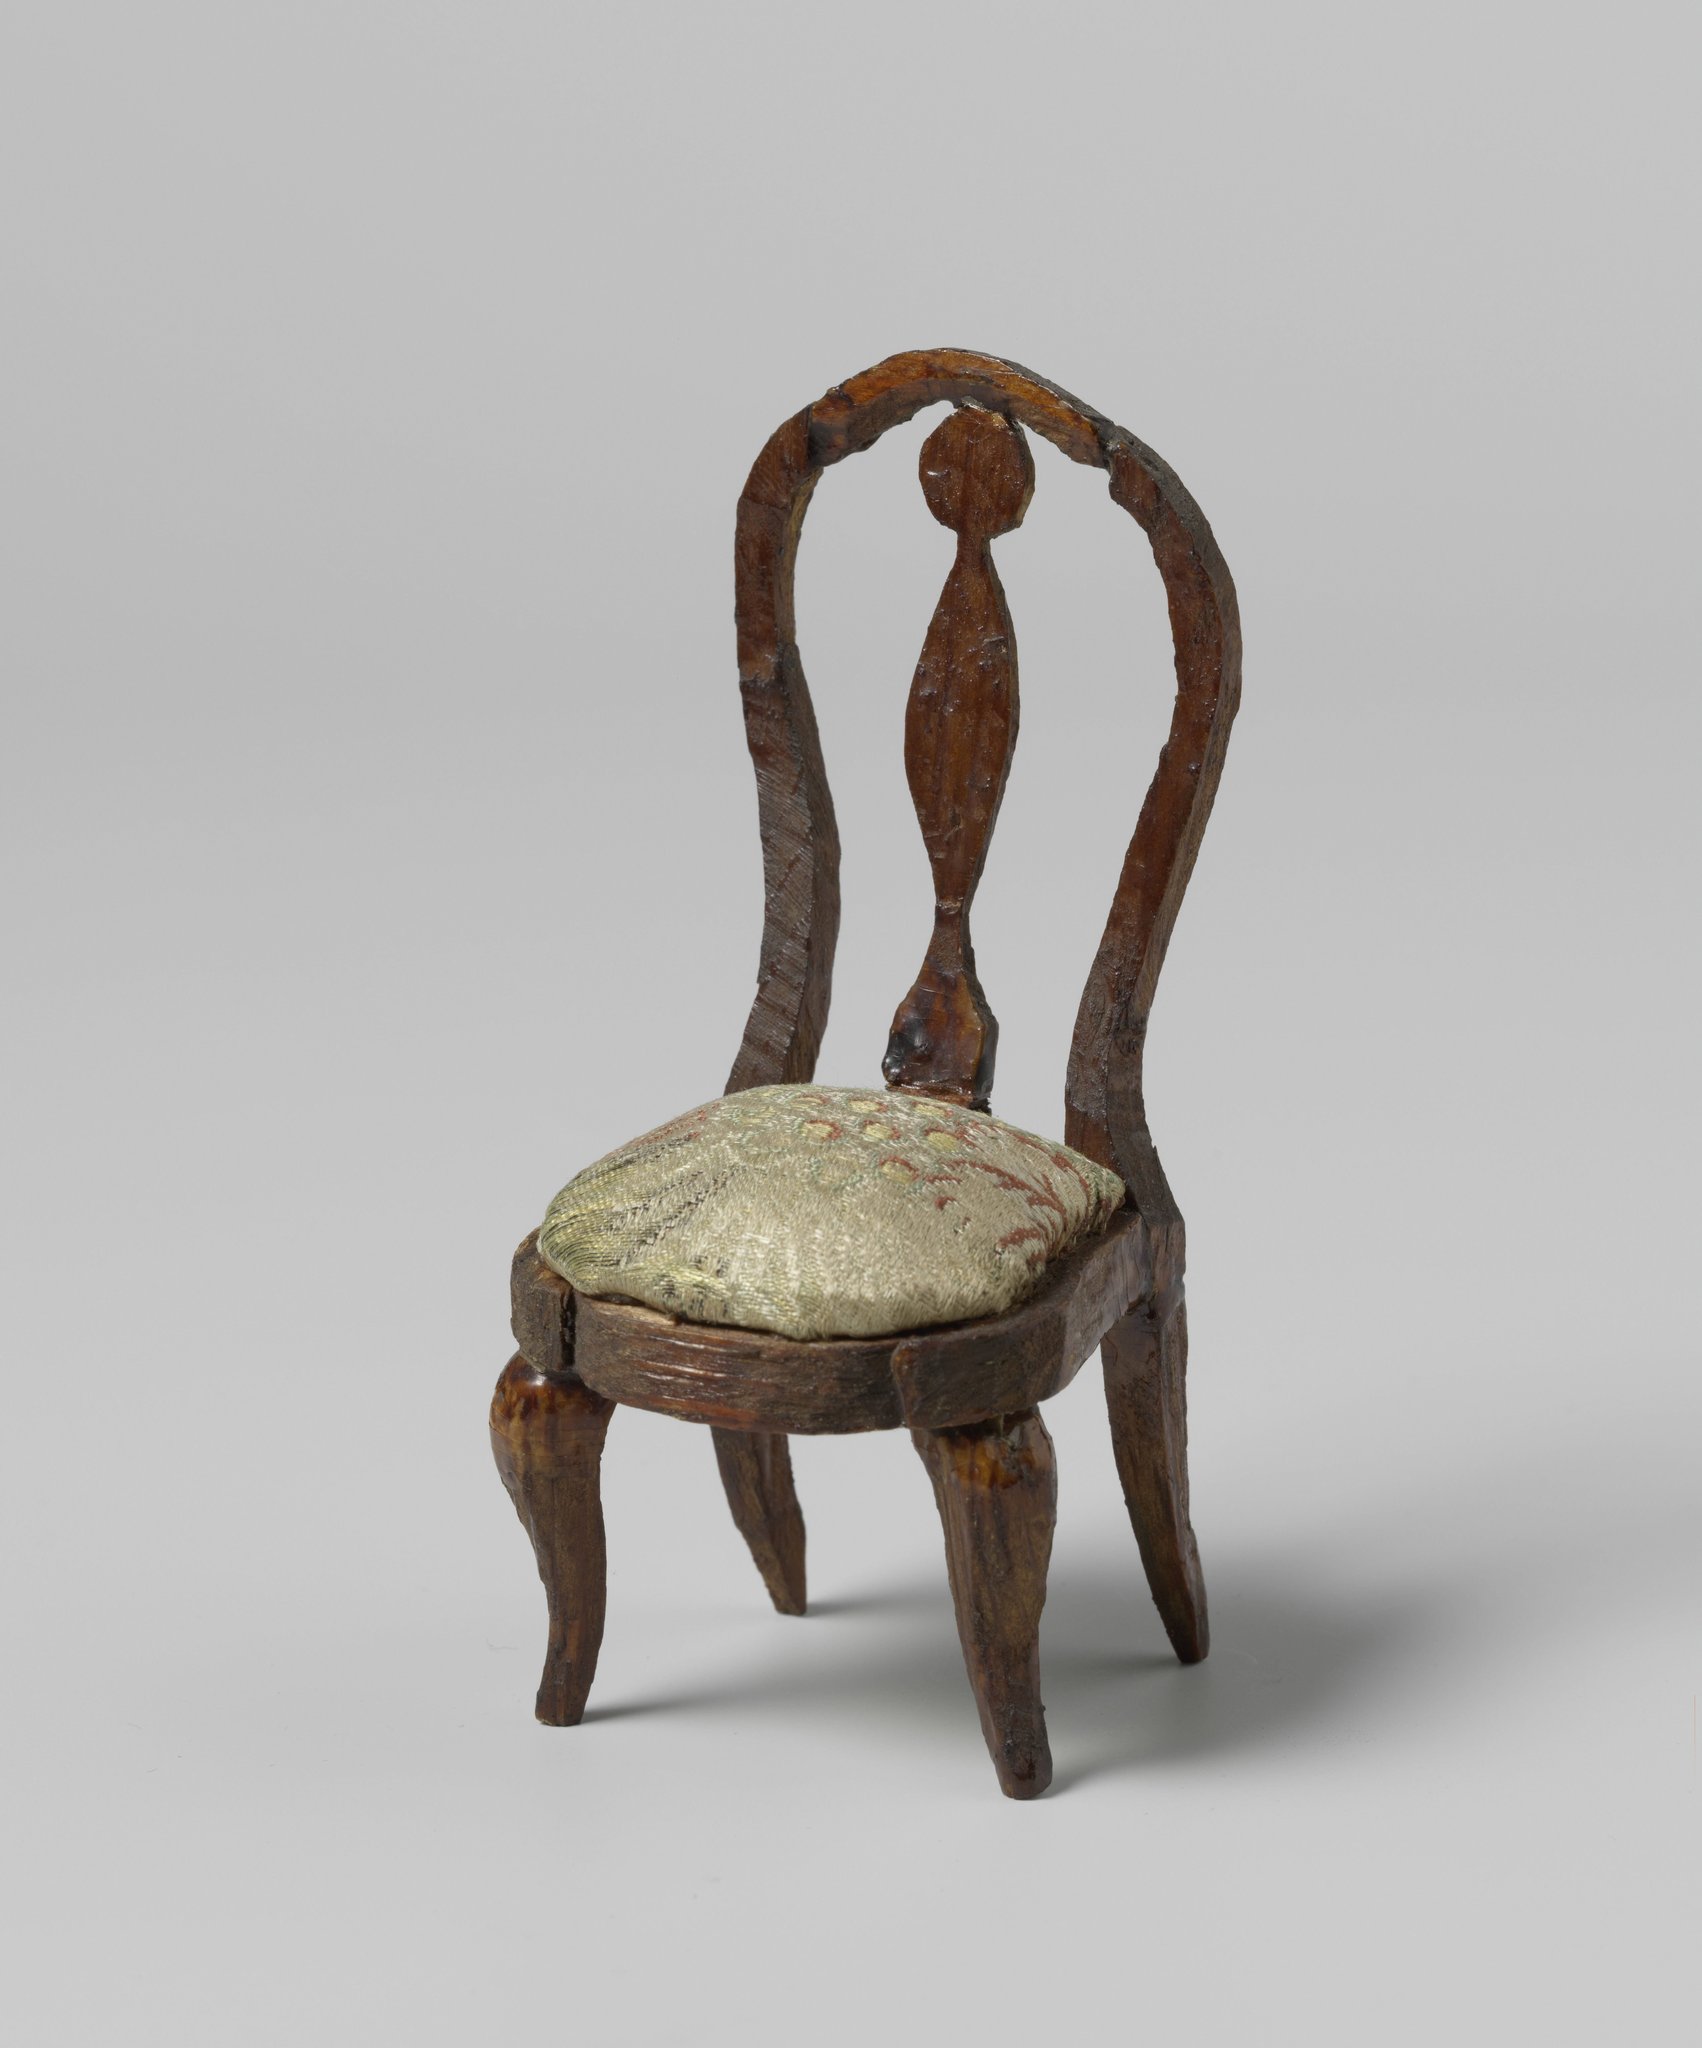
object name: chair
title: Stoel met ronde, open rugleuningen met middenstijl, de zitting met bloem- en bladmotieven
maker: Anonymous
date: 1750-1800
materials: silk, wood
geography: amsterdam